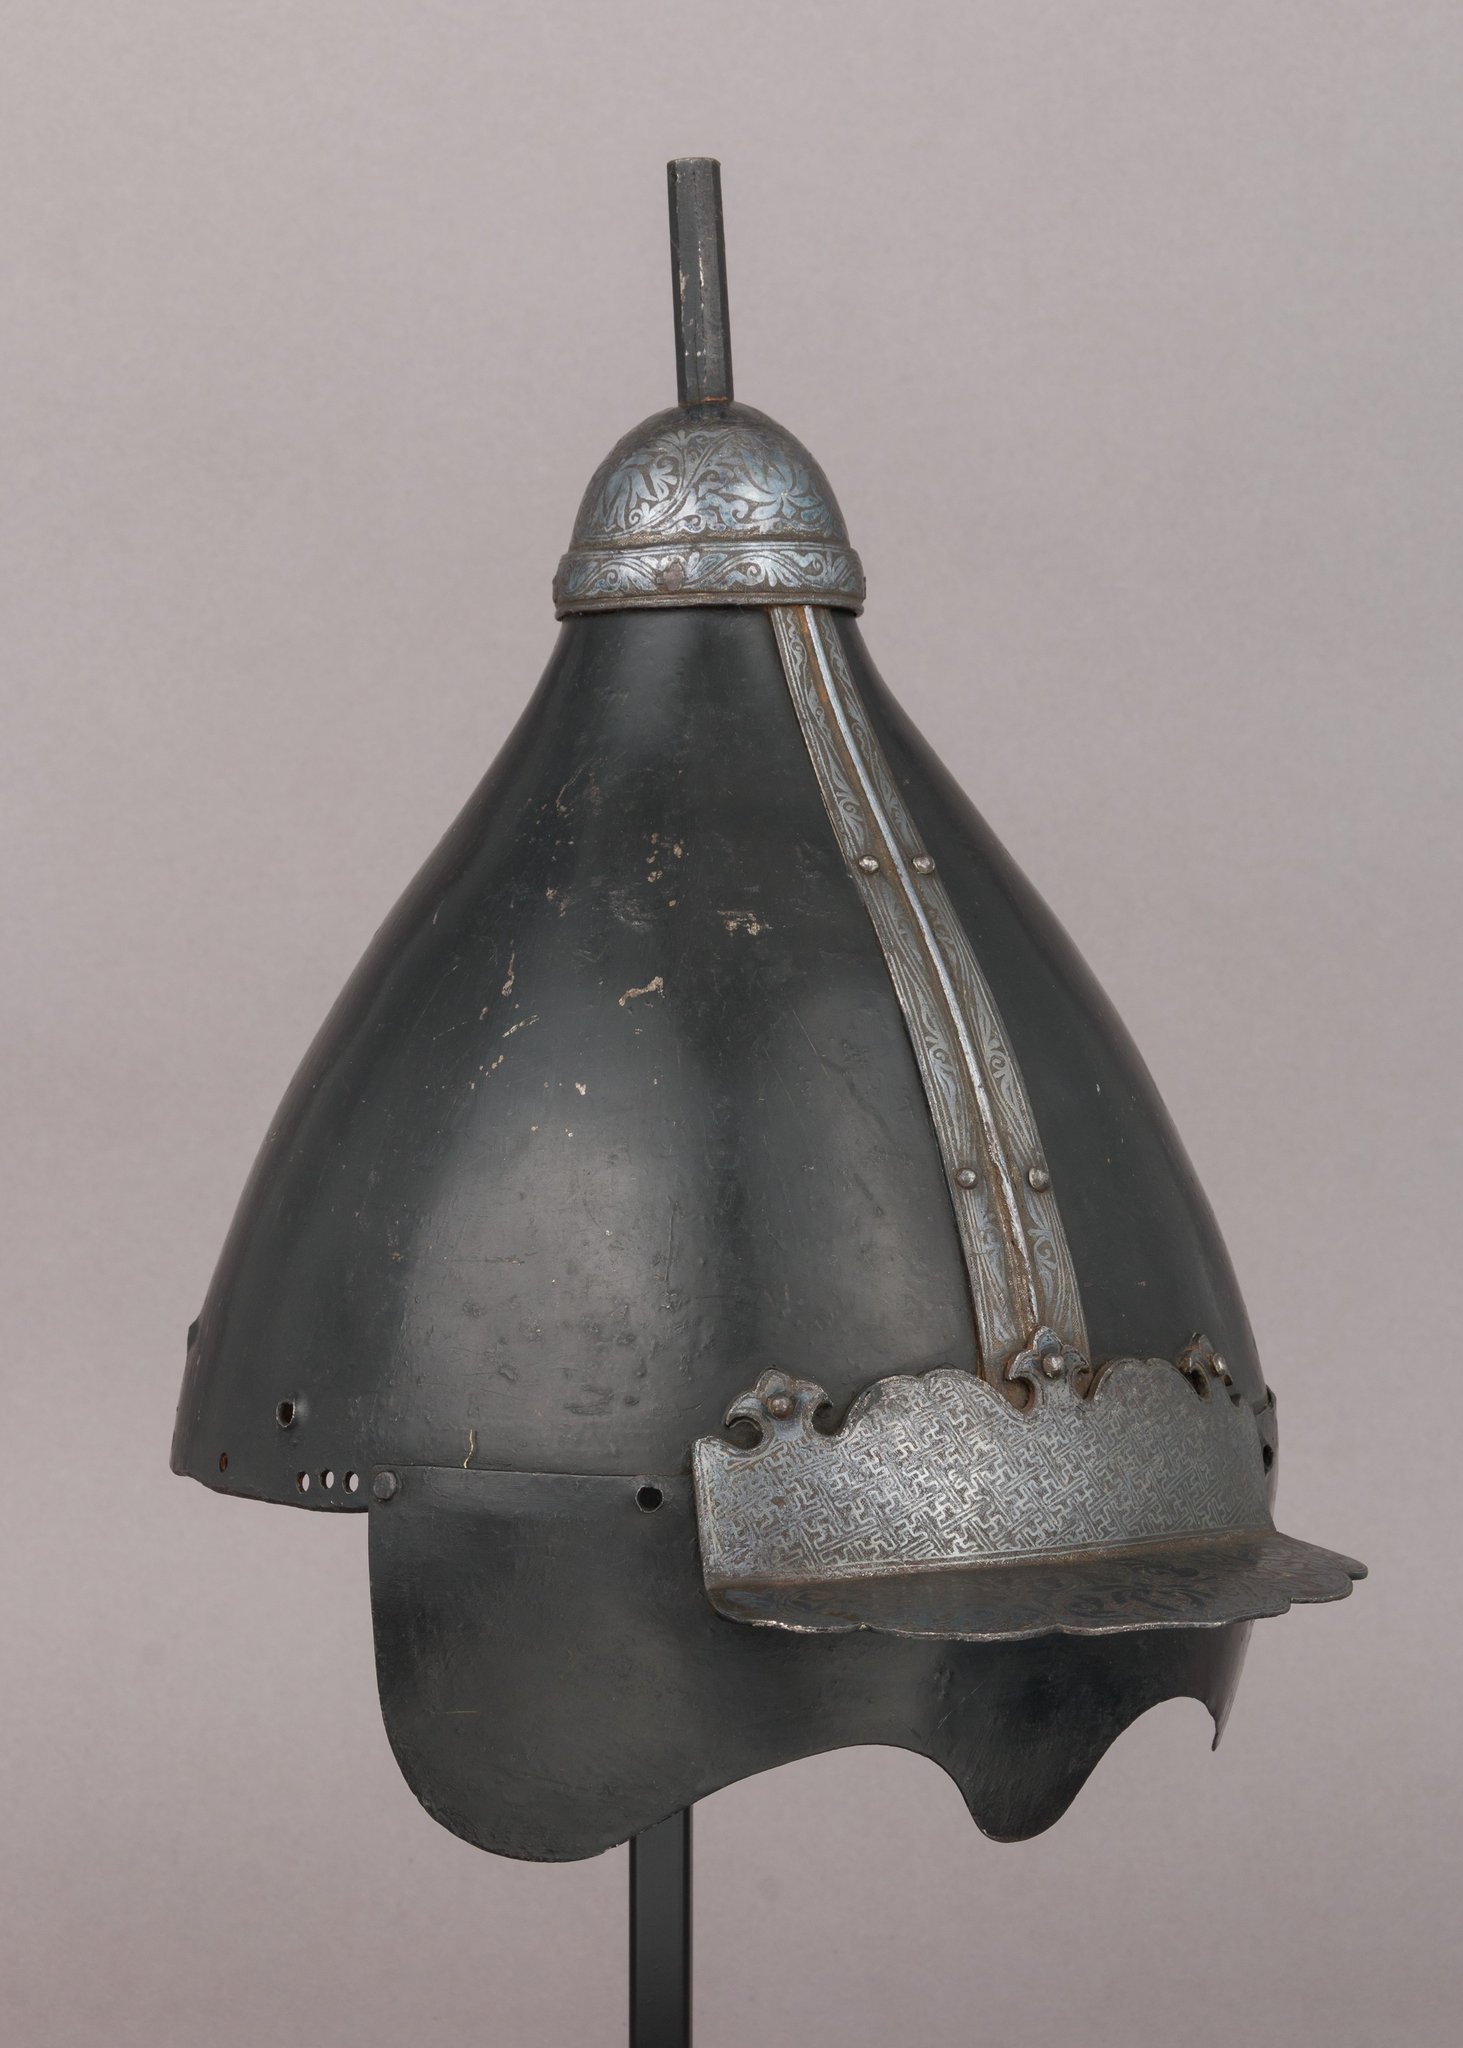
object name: helmet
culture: korean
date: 1601-1800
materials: iron, silver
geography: korea